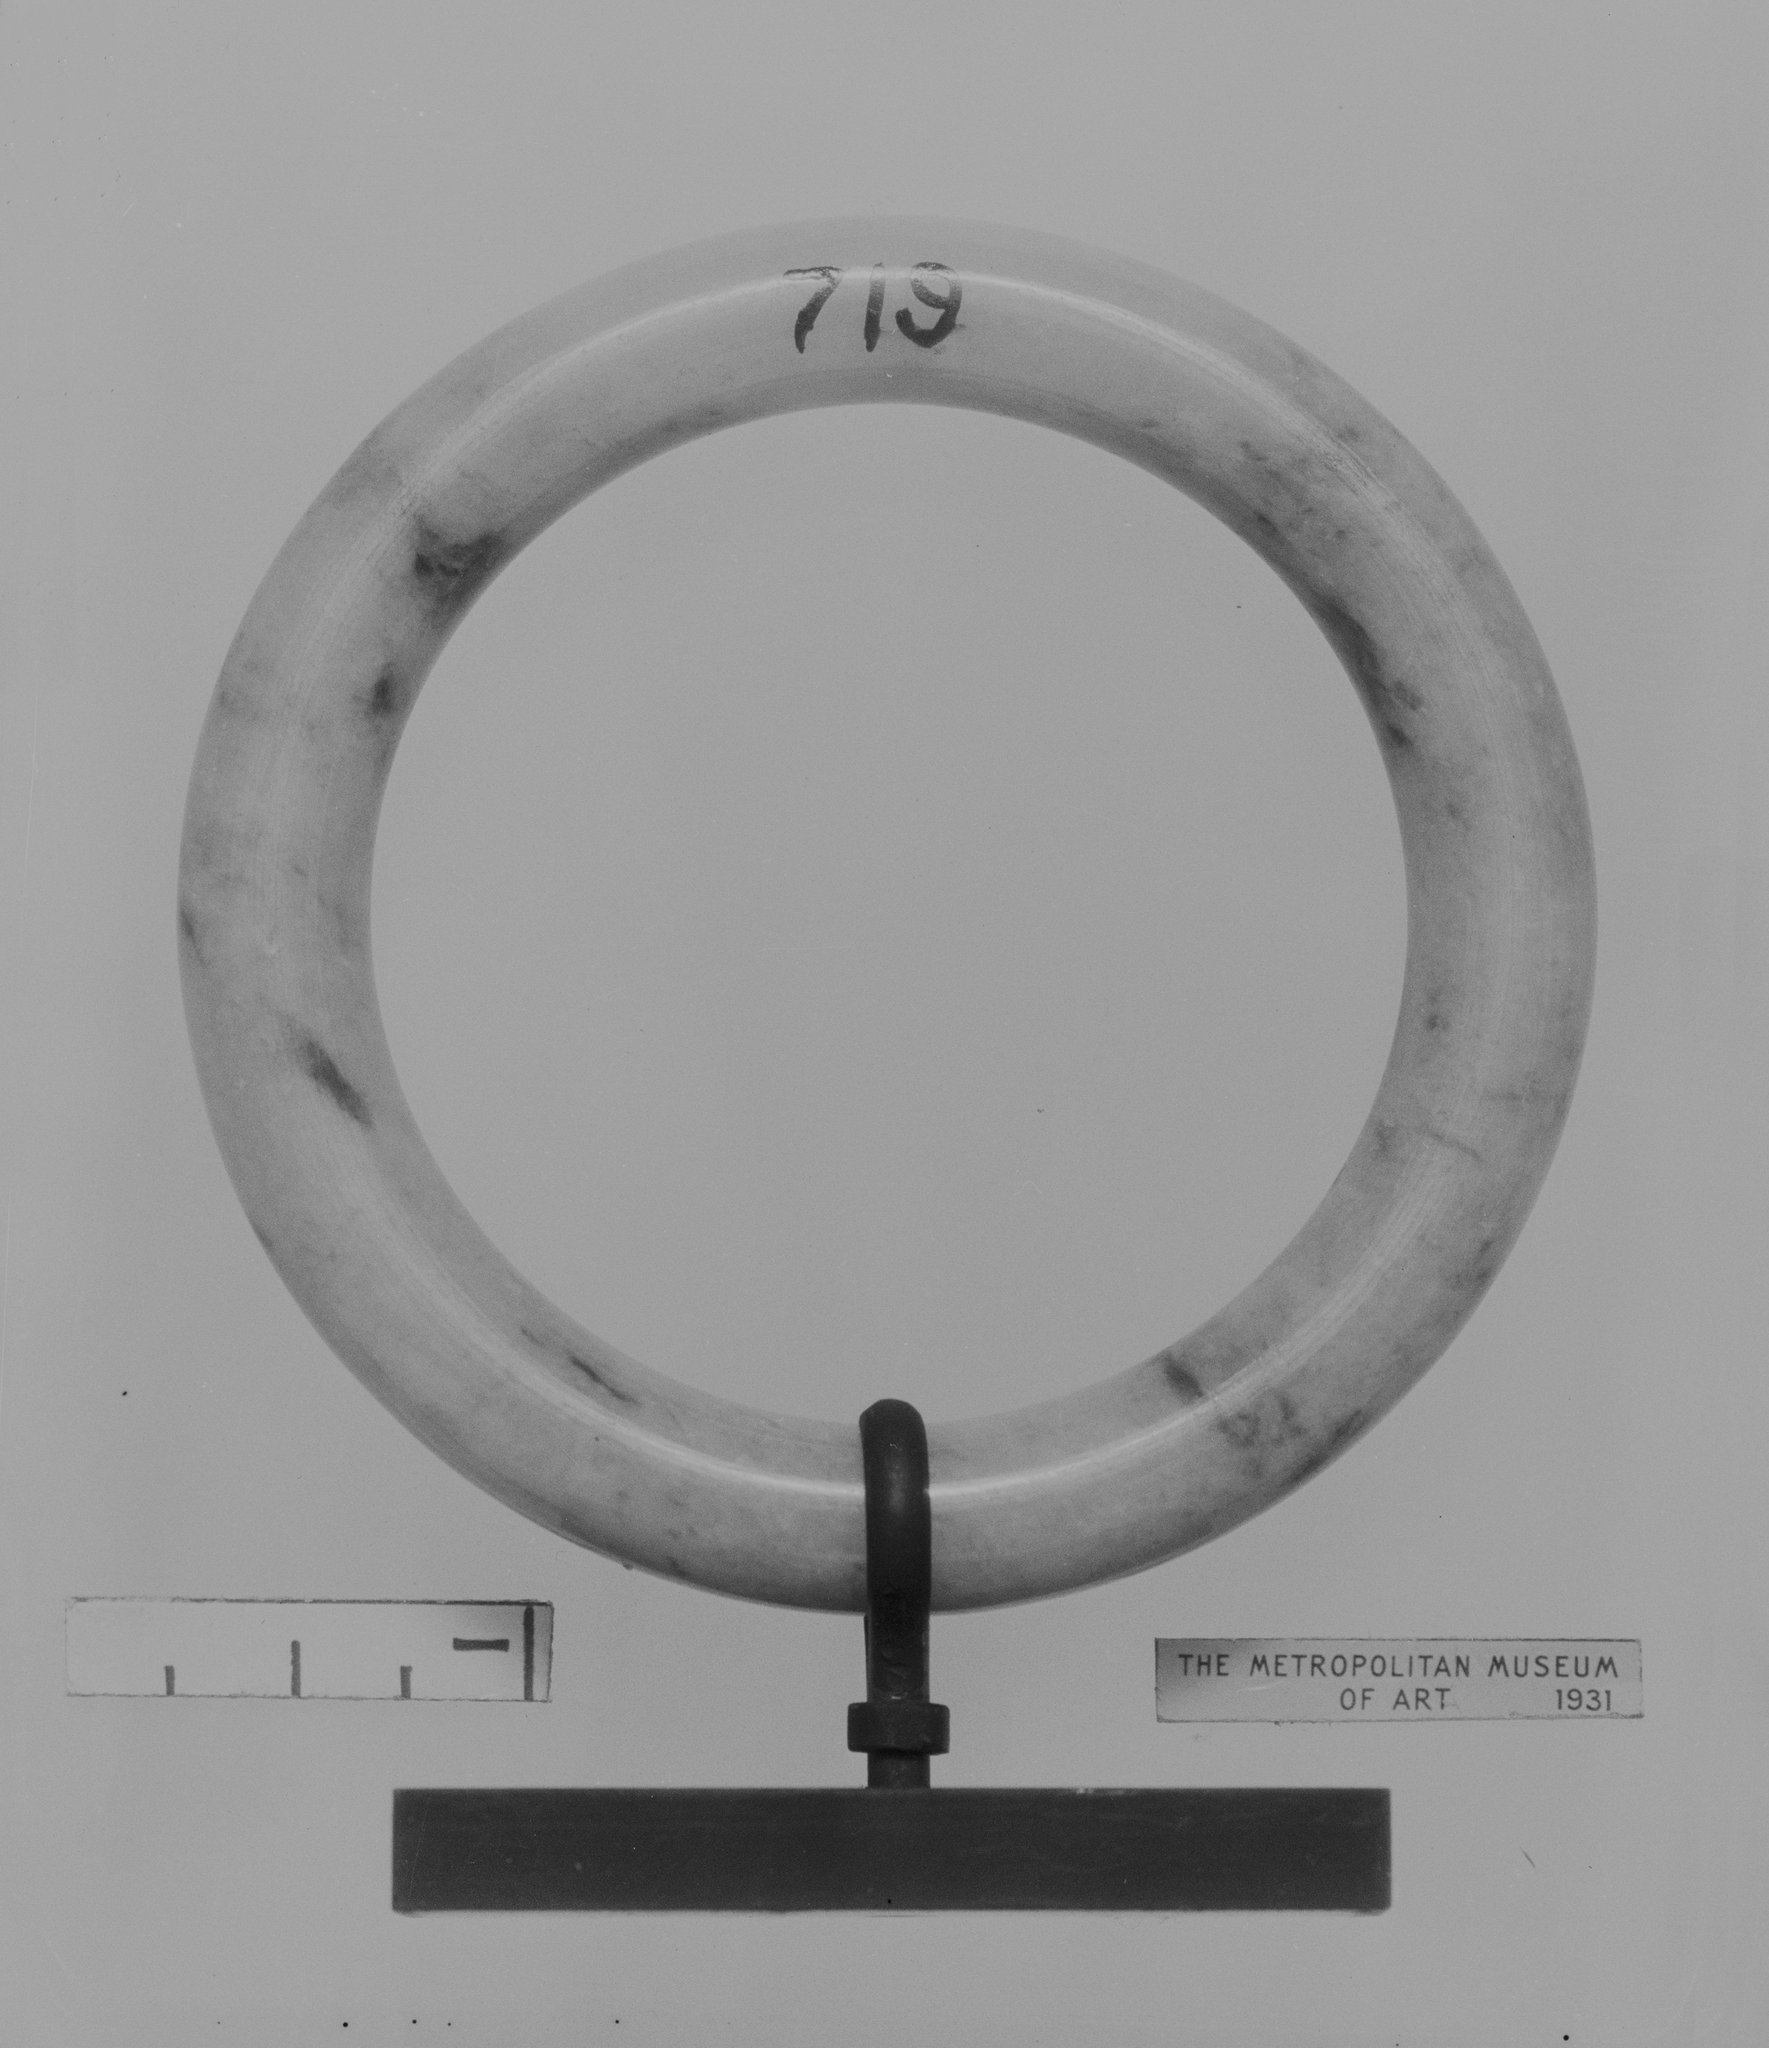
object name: armlet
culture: chinese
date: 1796-1875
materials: jade